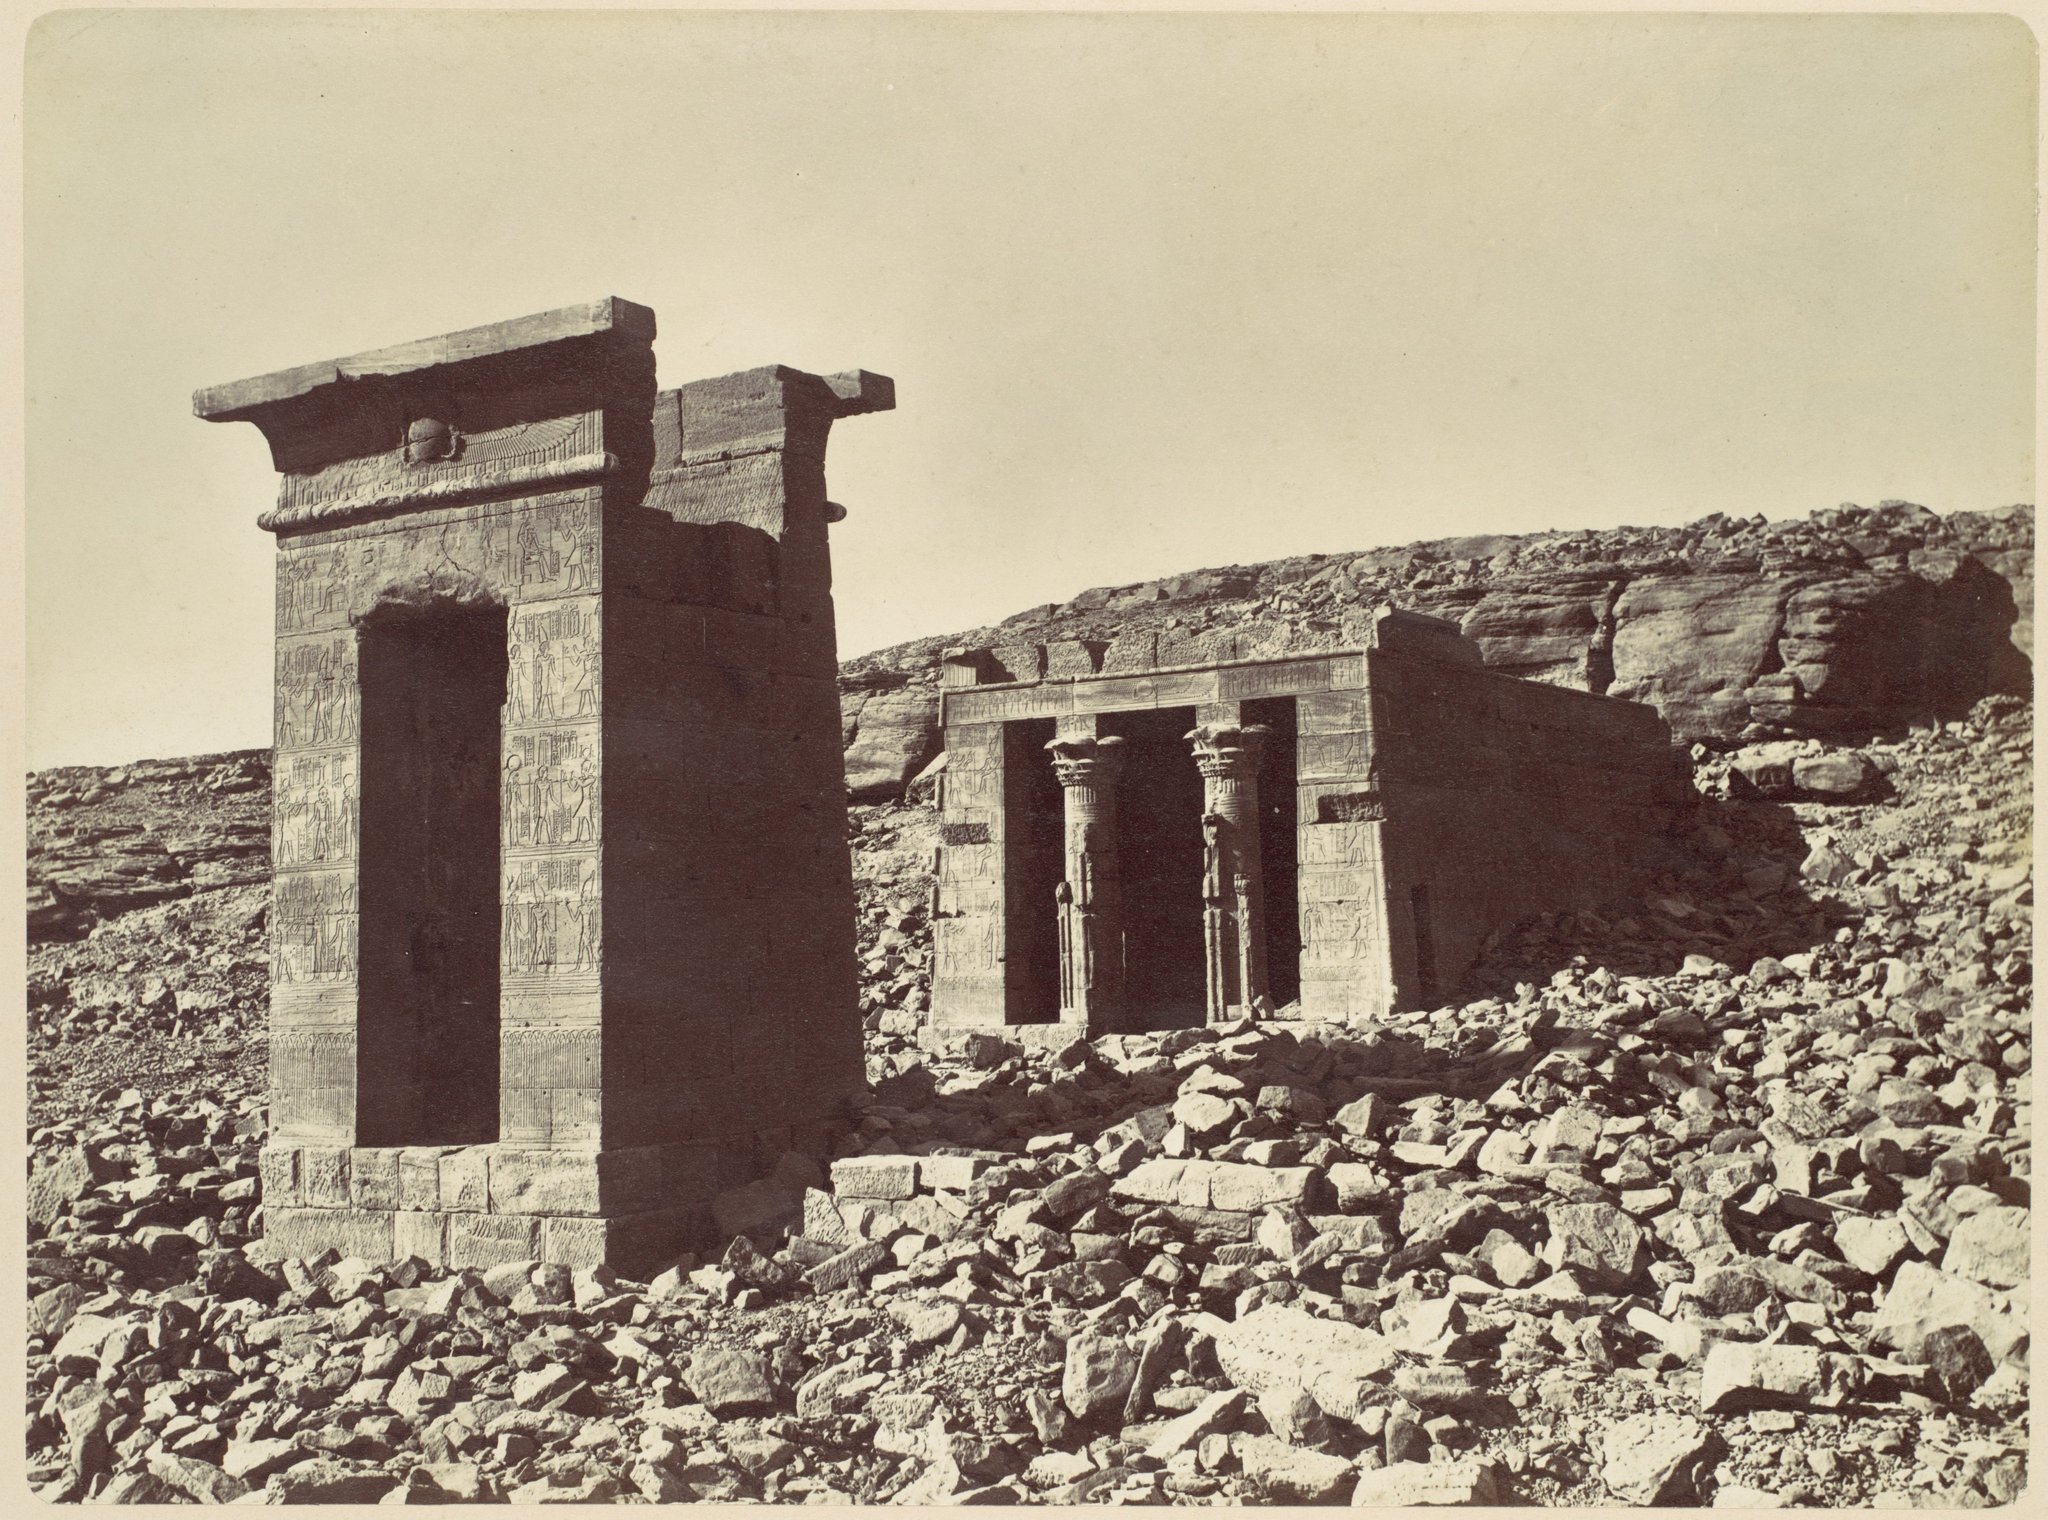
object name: photograph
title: Temple d'Andour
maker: félix bonfils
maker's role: fotograaf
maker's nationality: french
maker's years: 1831-1885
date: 1870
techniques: albumen silver print, glass negative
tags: architecture,ruins